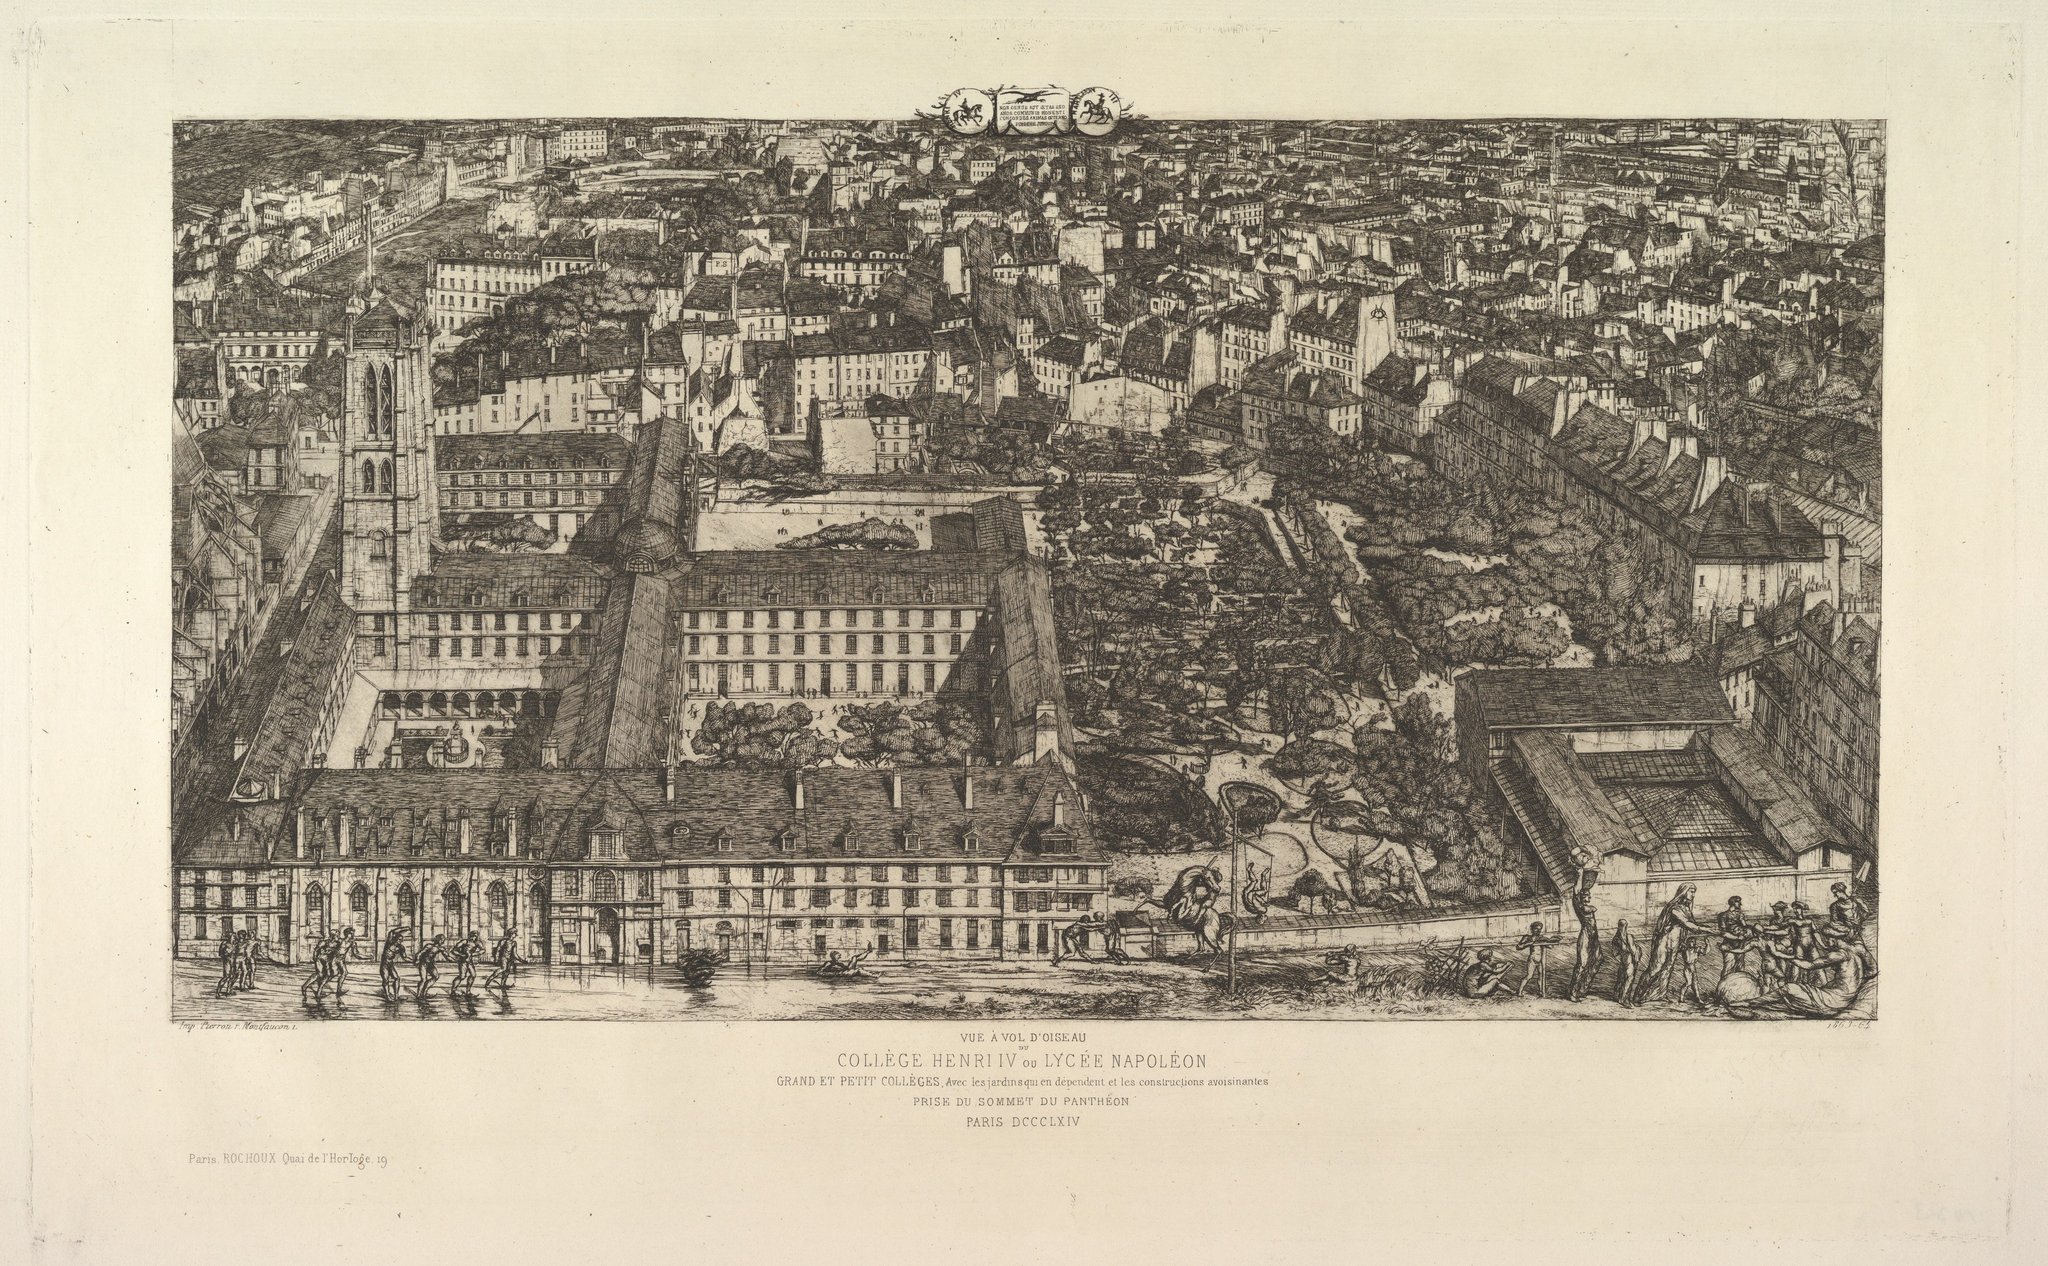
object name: print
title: Collège Henri IV (ou Lycée Napoléon)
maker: charles meryon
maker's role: artist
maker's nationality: french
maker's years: 1821-1868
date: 1863-1864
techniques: etching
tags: buildings,men,horses,trees